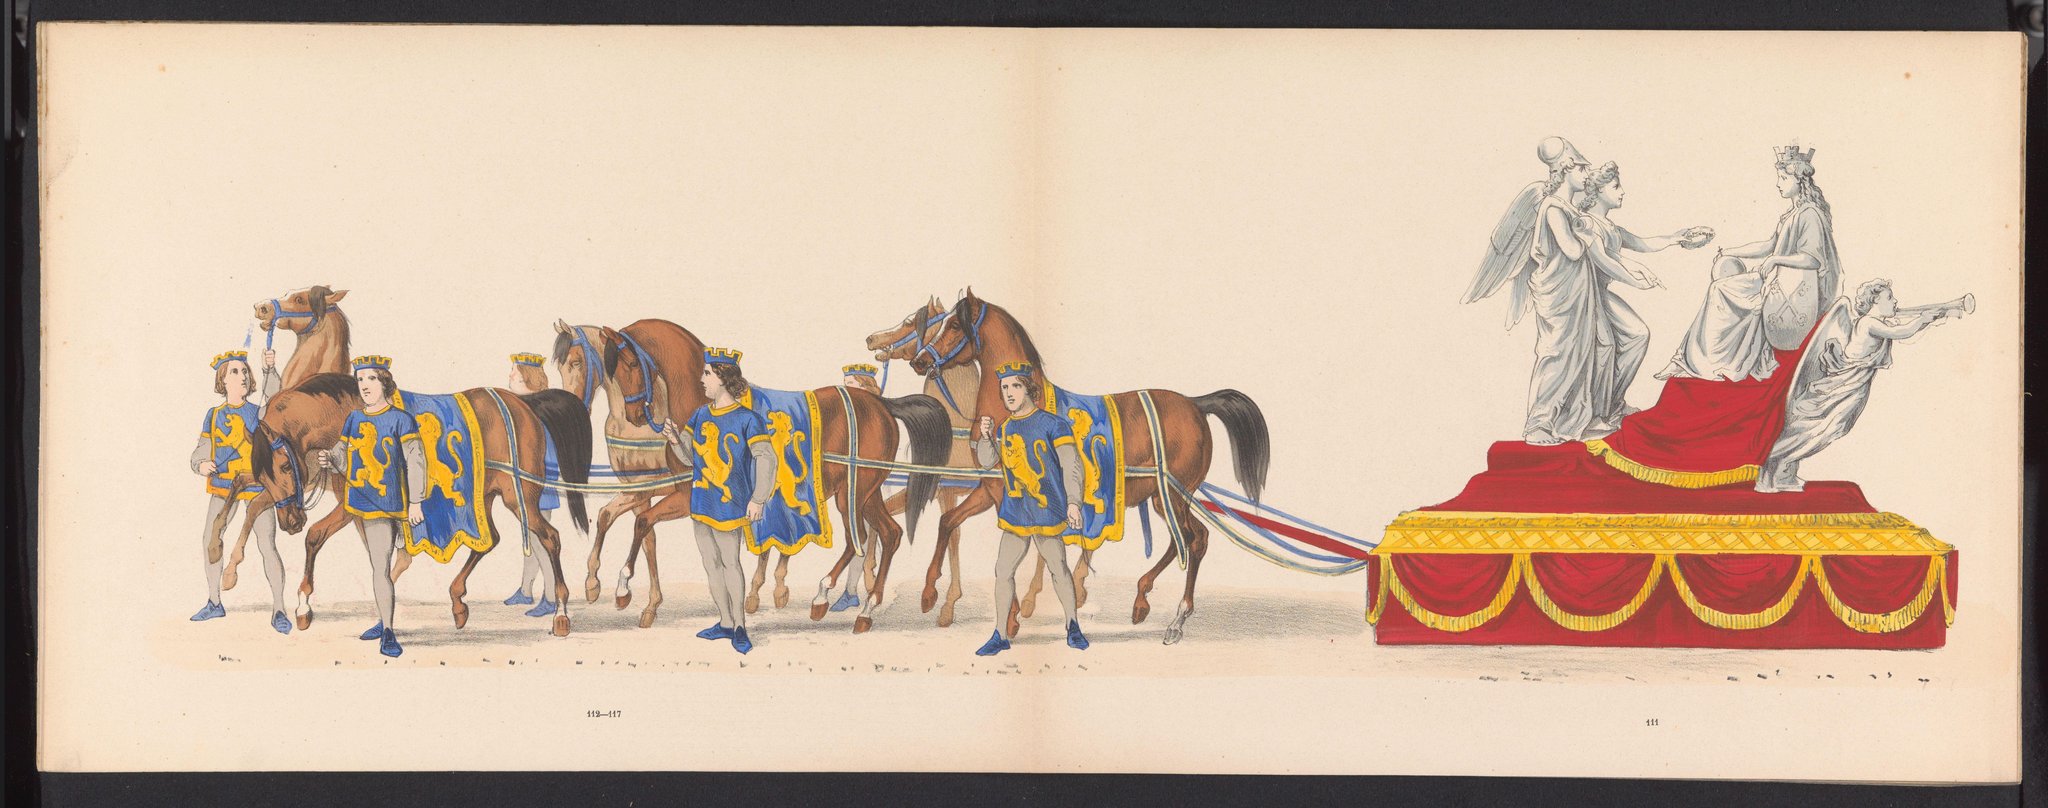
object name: print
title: Maskerade van de Leidse studenten, 1875 (plaat 7)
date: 1875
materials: paper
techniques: hand coloring, lithograph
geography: netherlands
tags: students' pageant, costumes used in pageants, leiden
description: Historische gekostumeerde optocht van de studenten van de Leidse Hogeschool gehouden op 15 juni 1875 ter gelegenheid van het 300-jarig bestaan van de Hogeschool. De optocht verbeeldt de beroemdste mannen verbonden aan de Hogeschool. Zevende plaat met de groepen genummerd 112-117. Onderdeel van de serie van 21 aaneen geplakte bladen.